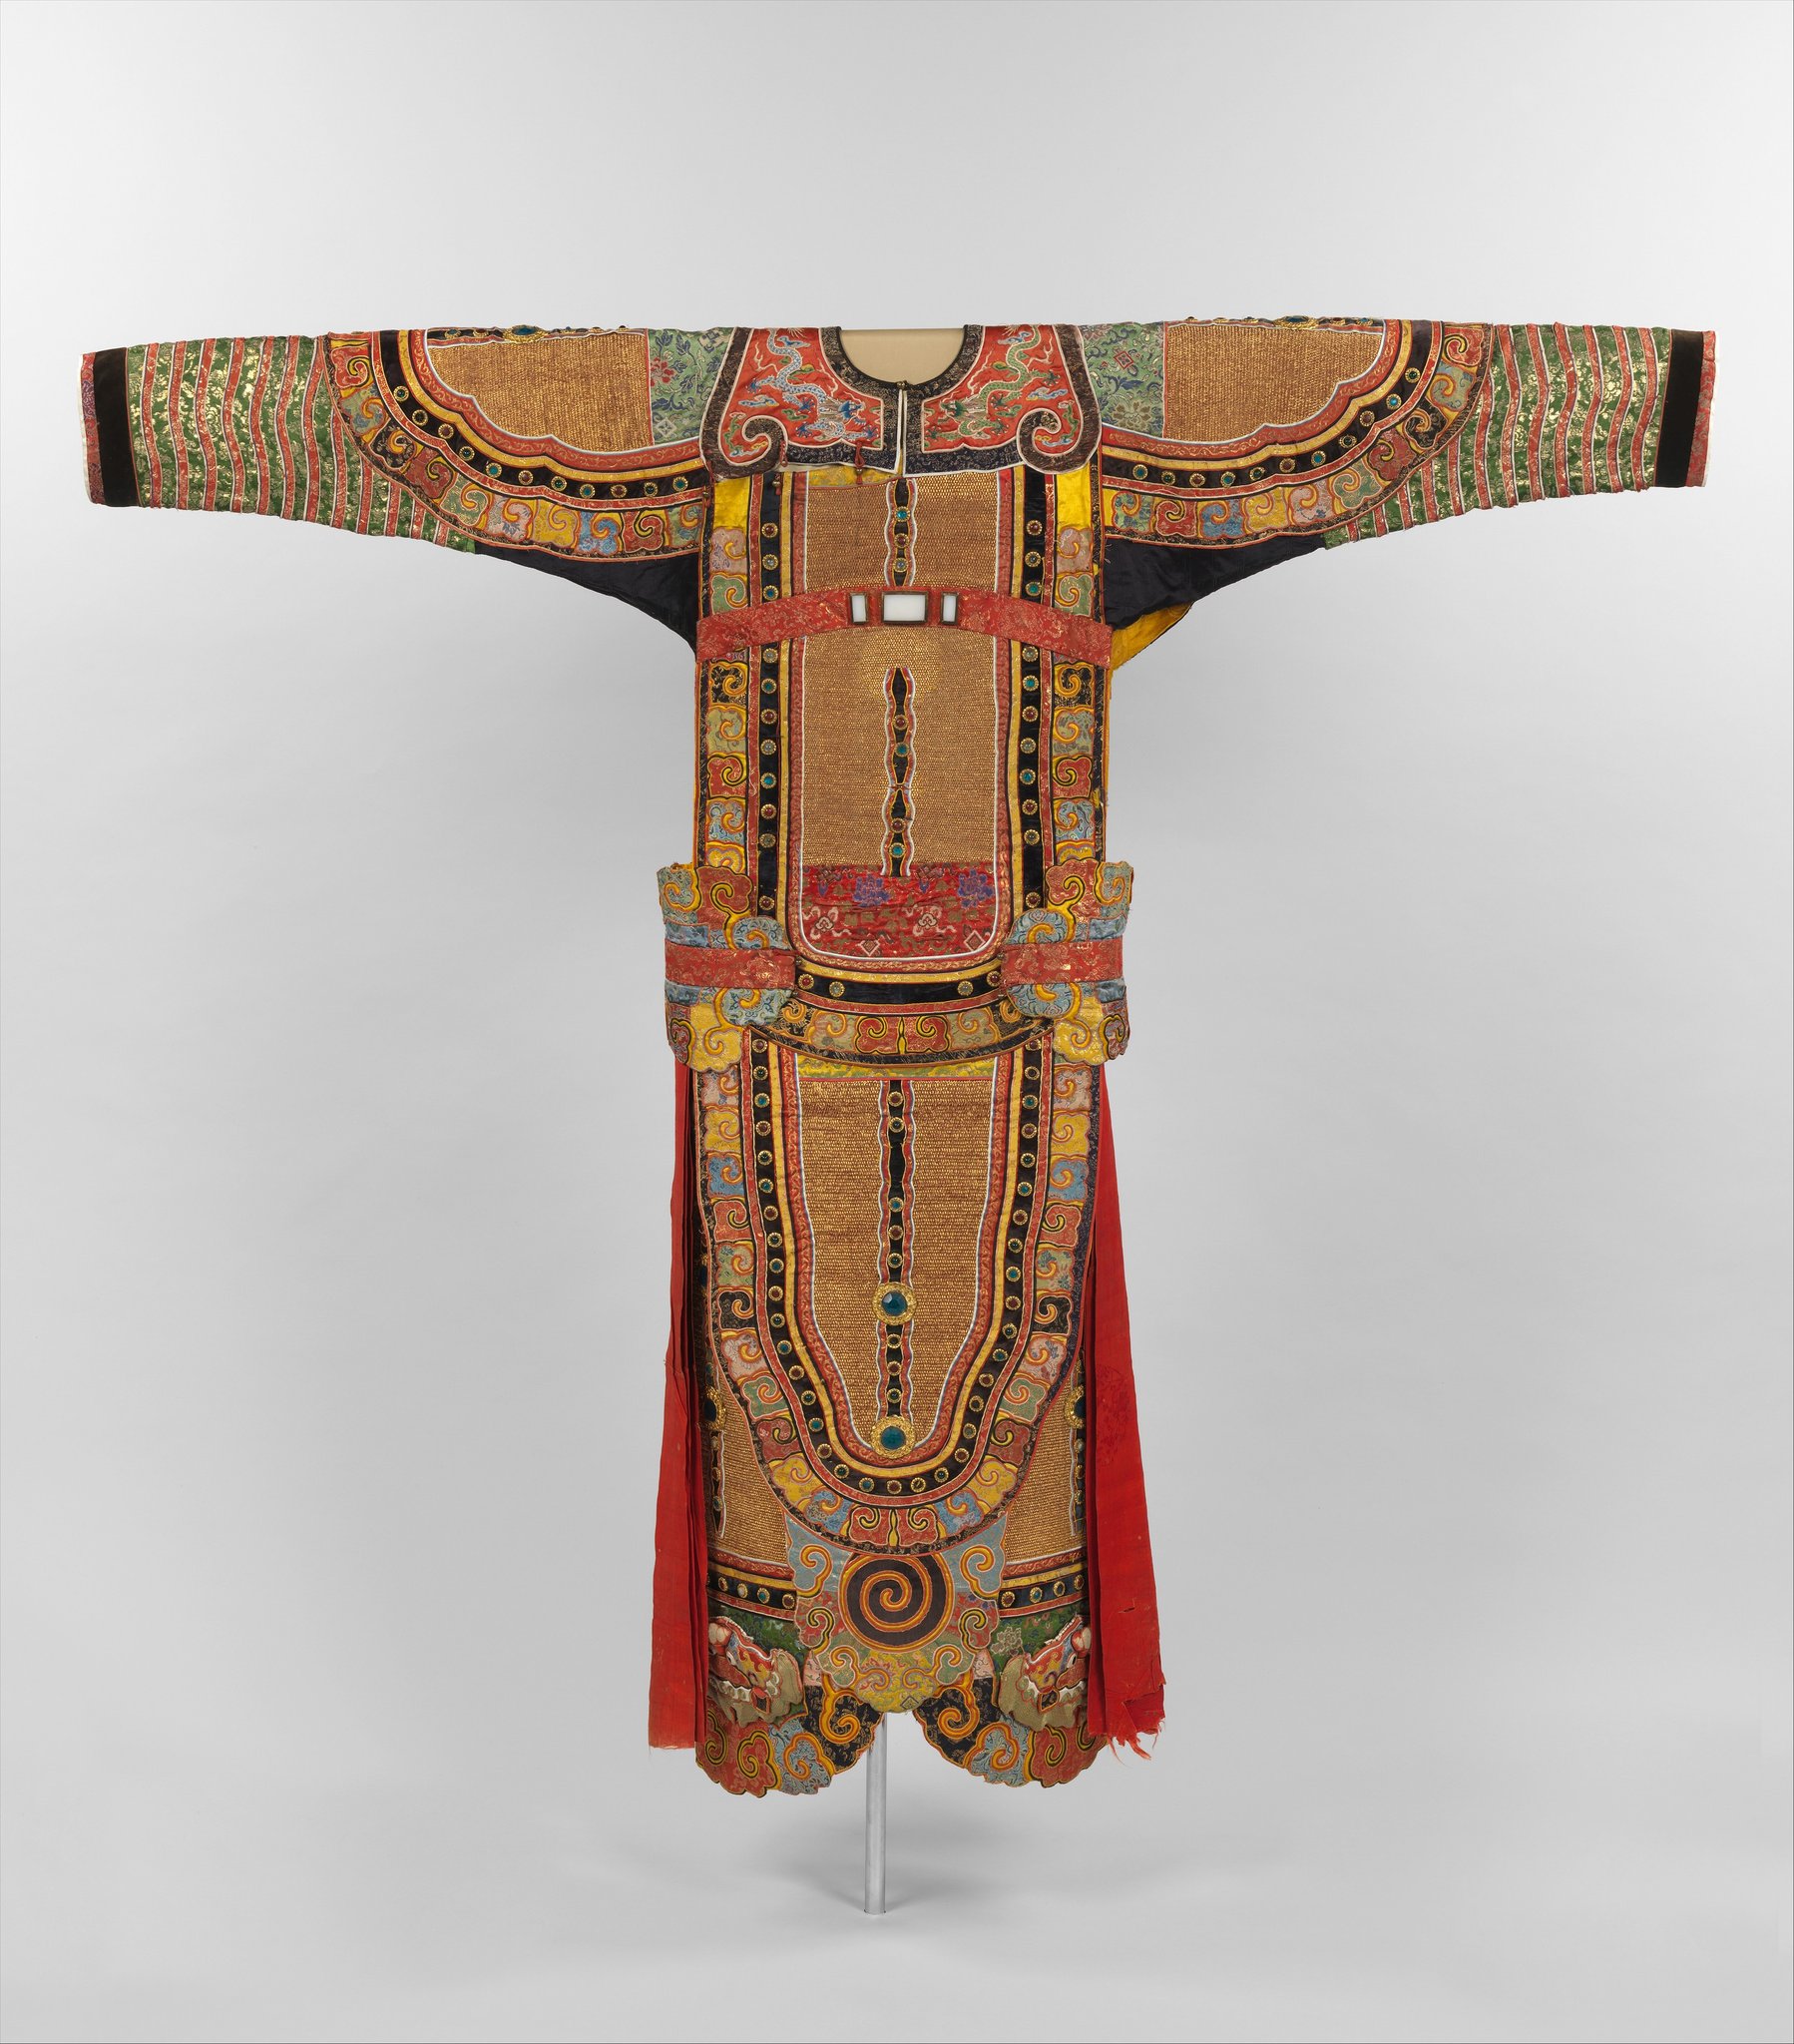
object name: robe, imperial theatrical, for a warrior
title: Theatrical Costume for the Role of a Warrior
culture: chinese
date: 1701-1800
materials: glass, metal, metal thread, silk